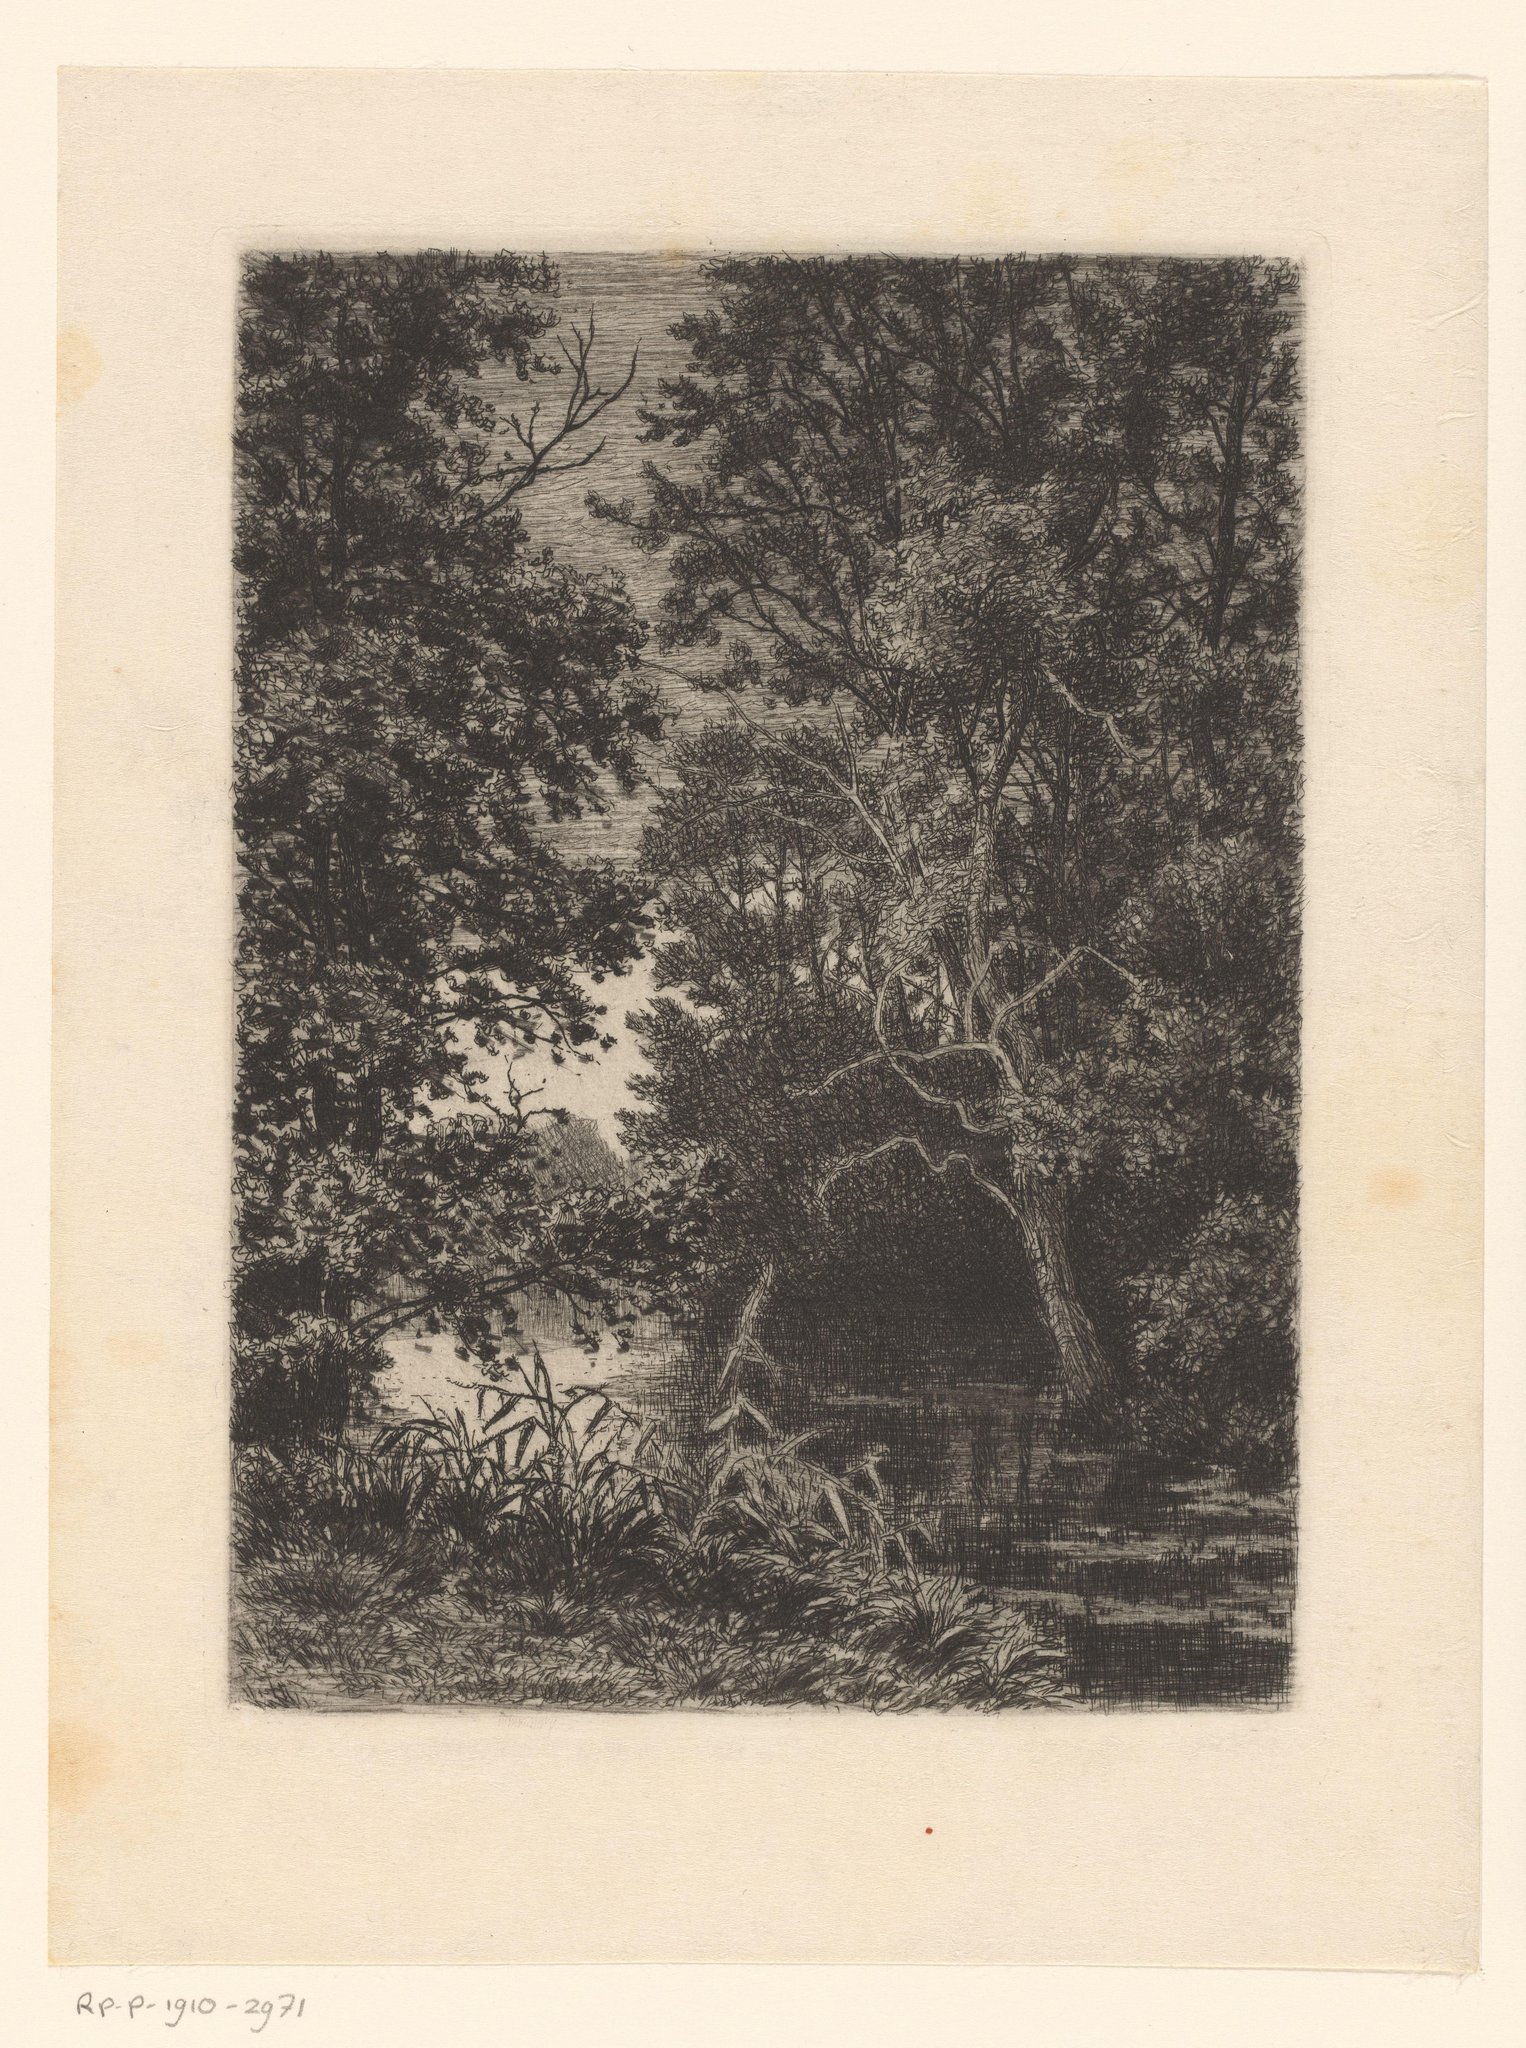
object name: print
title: Bebossing rondom een meer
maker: alfred elsen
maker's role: painter, print maker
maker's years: 1850-1914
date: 1860-1910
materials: paper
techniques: etching, intaglio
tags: lake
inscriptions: collector's mark: Lugt 2228